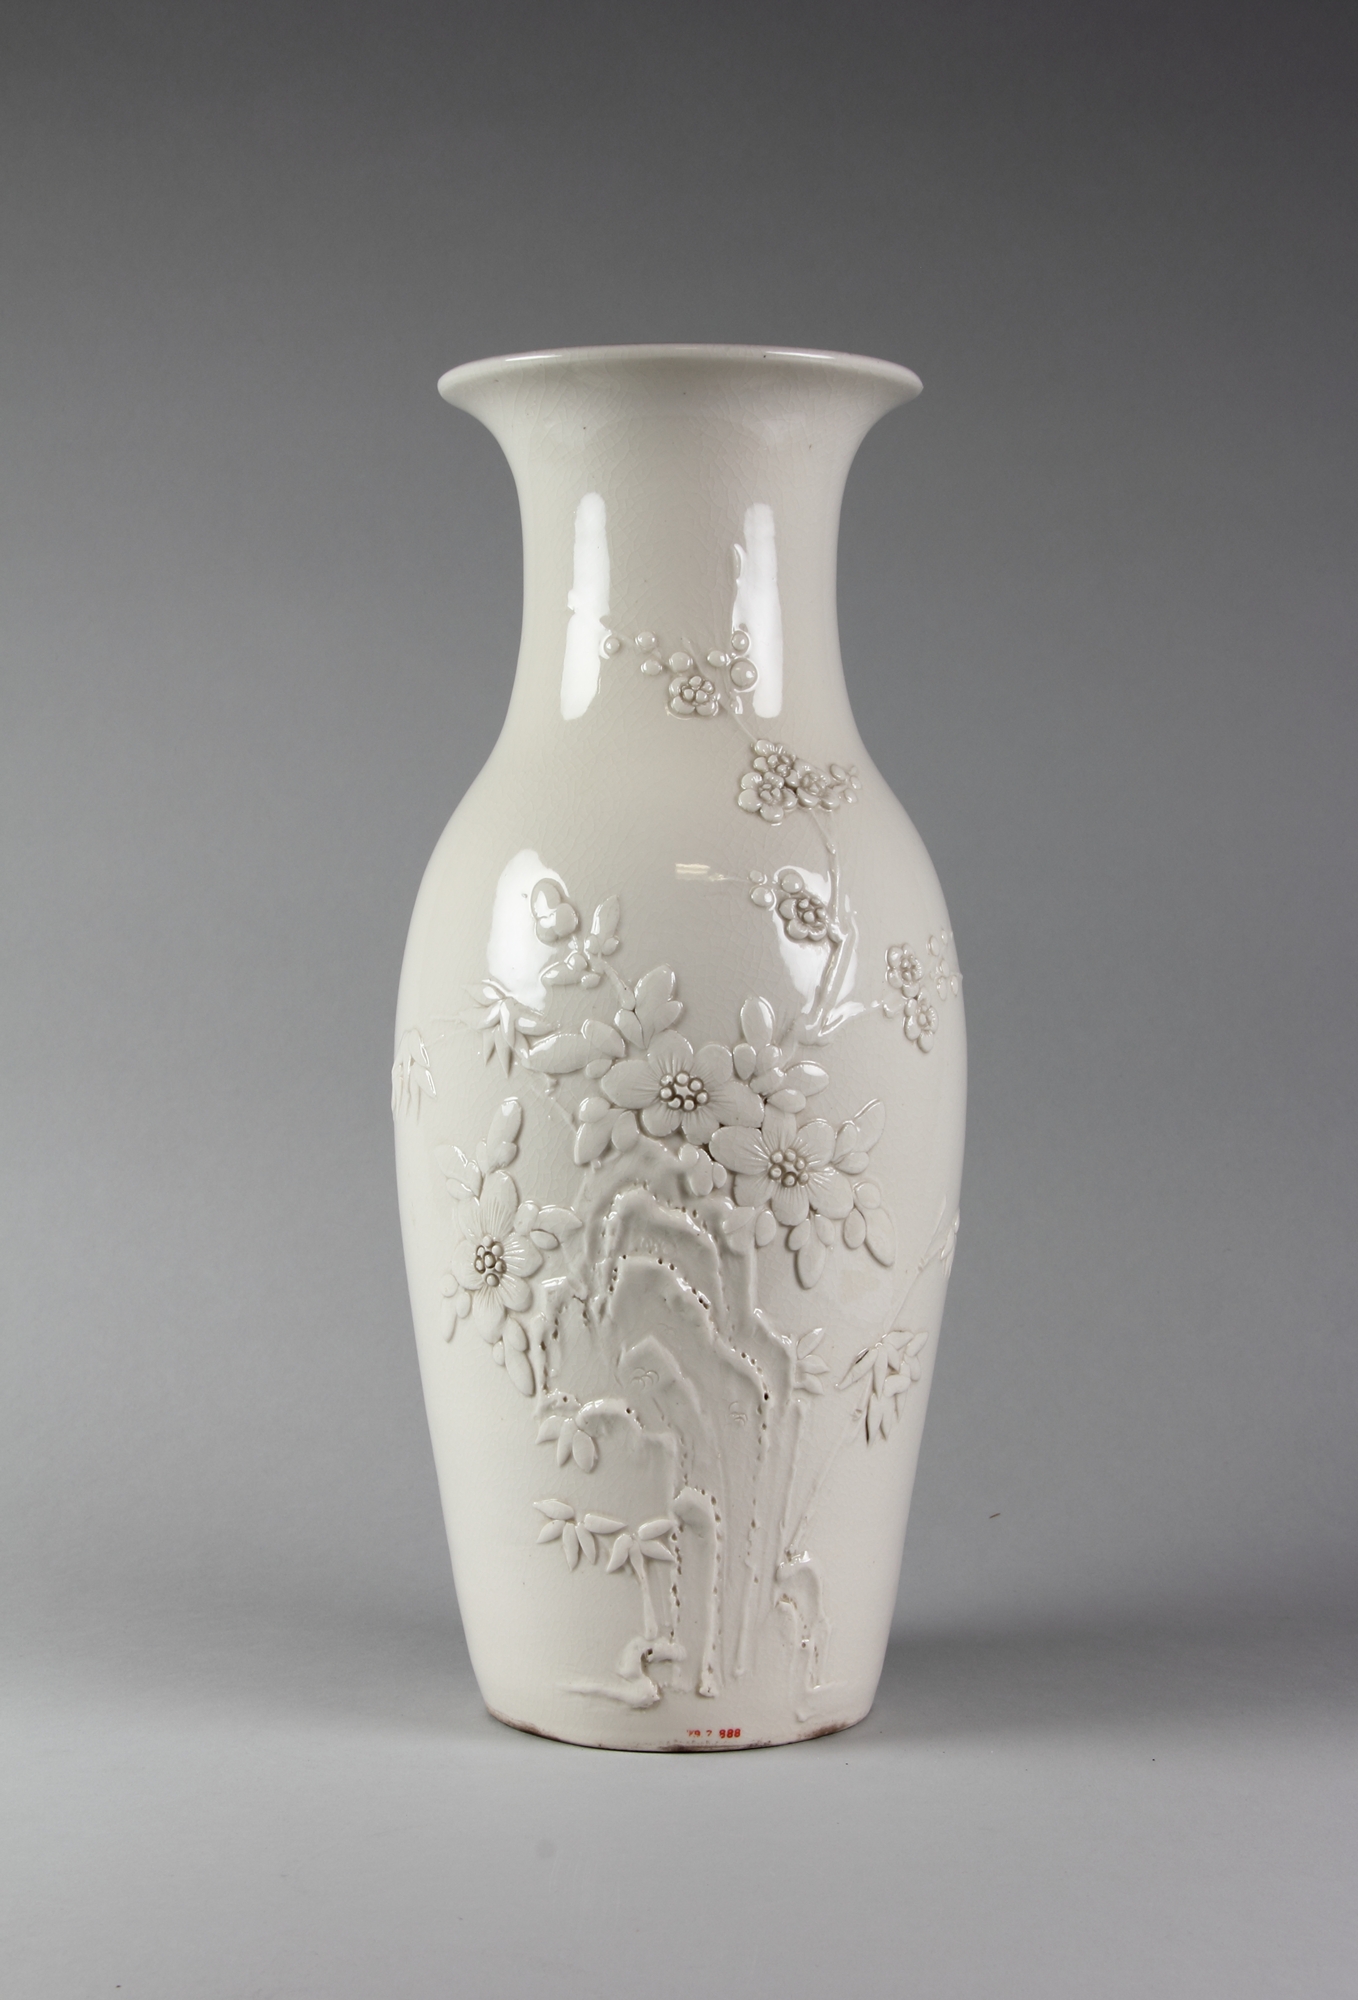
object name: vase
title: Vase with flowers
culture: chinese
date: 1801-1833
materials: porcelain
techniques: relief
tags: flowers,leaves